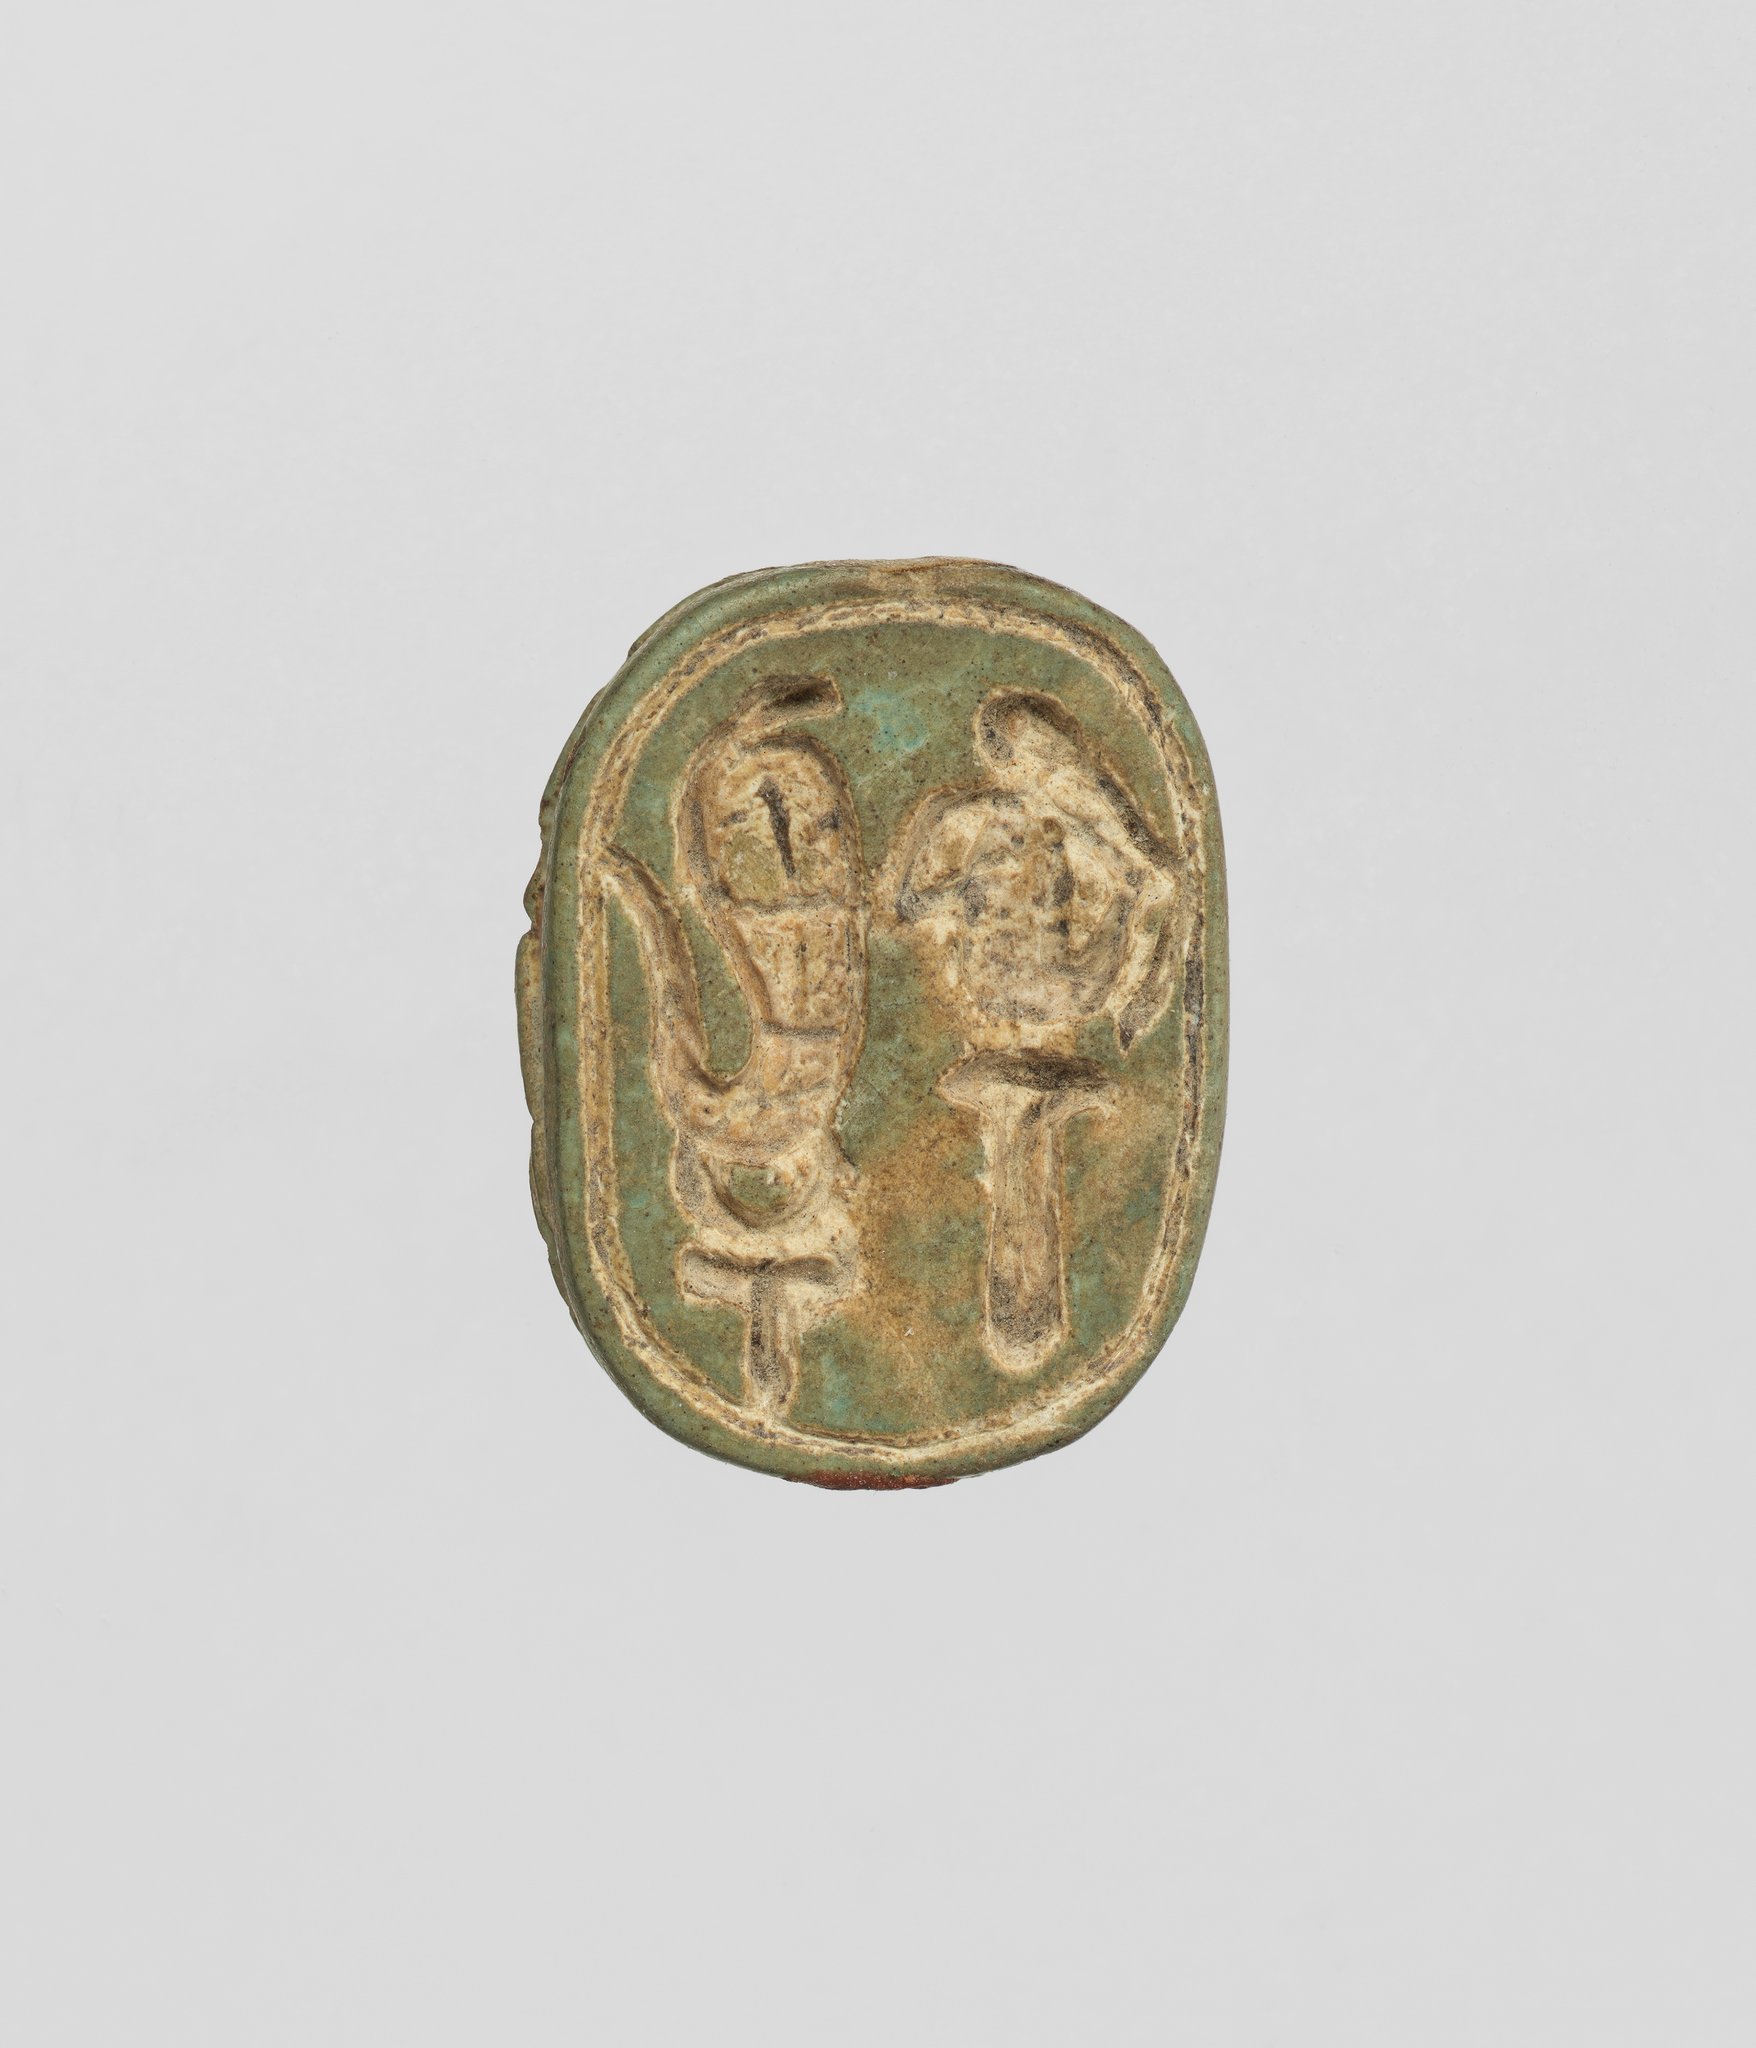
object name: scarab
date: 1295-1070 BCE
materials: faience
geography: egypt